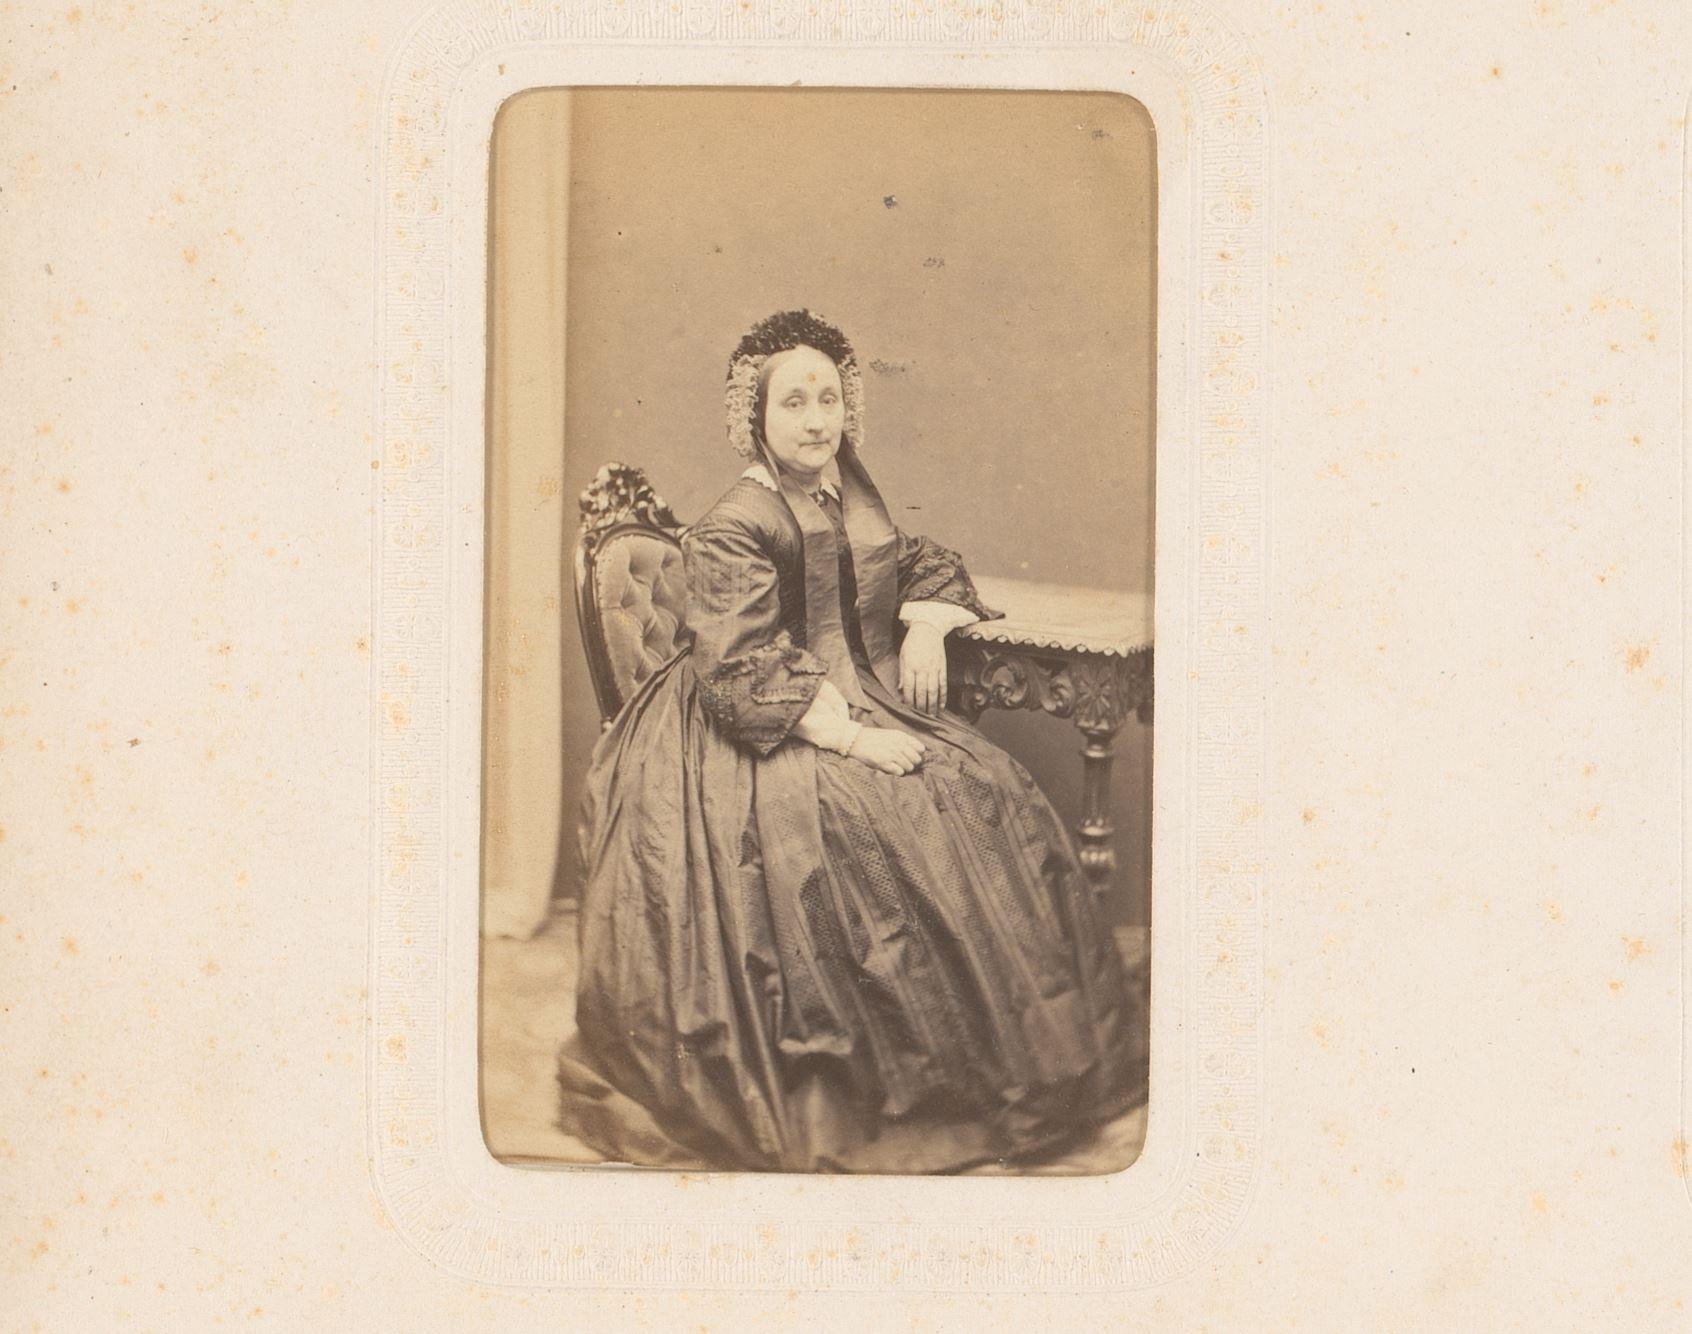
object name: photograph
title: Portret van een vrouw met muts, zittend aan een tafel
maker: Anonymous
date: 1860-1900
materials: cardboard, photographic support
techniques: albumen print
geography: netherlands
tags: sitting figure - aa - female human figure, historical persons - bb - woman, table, head-gear: cap